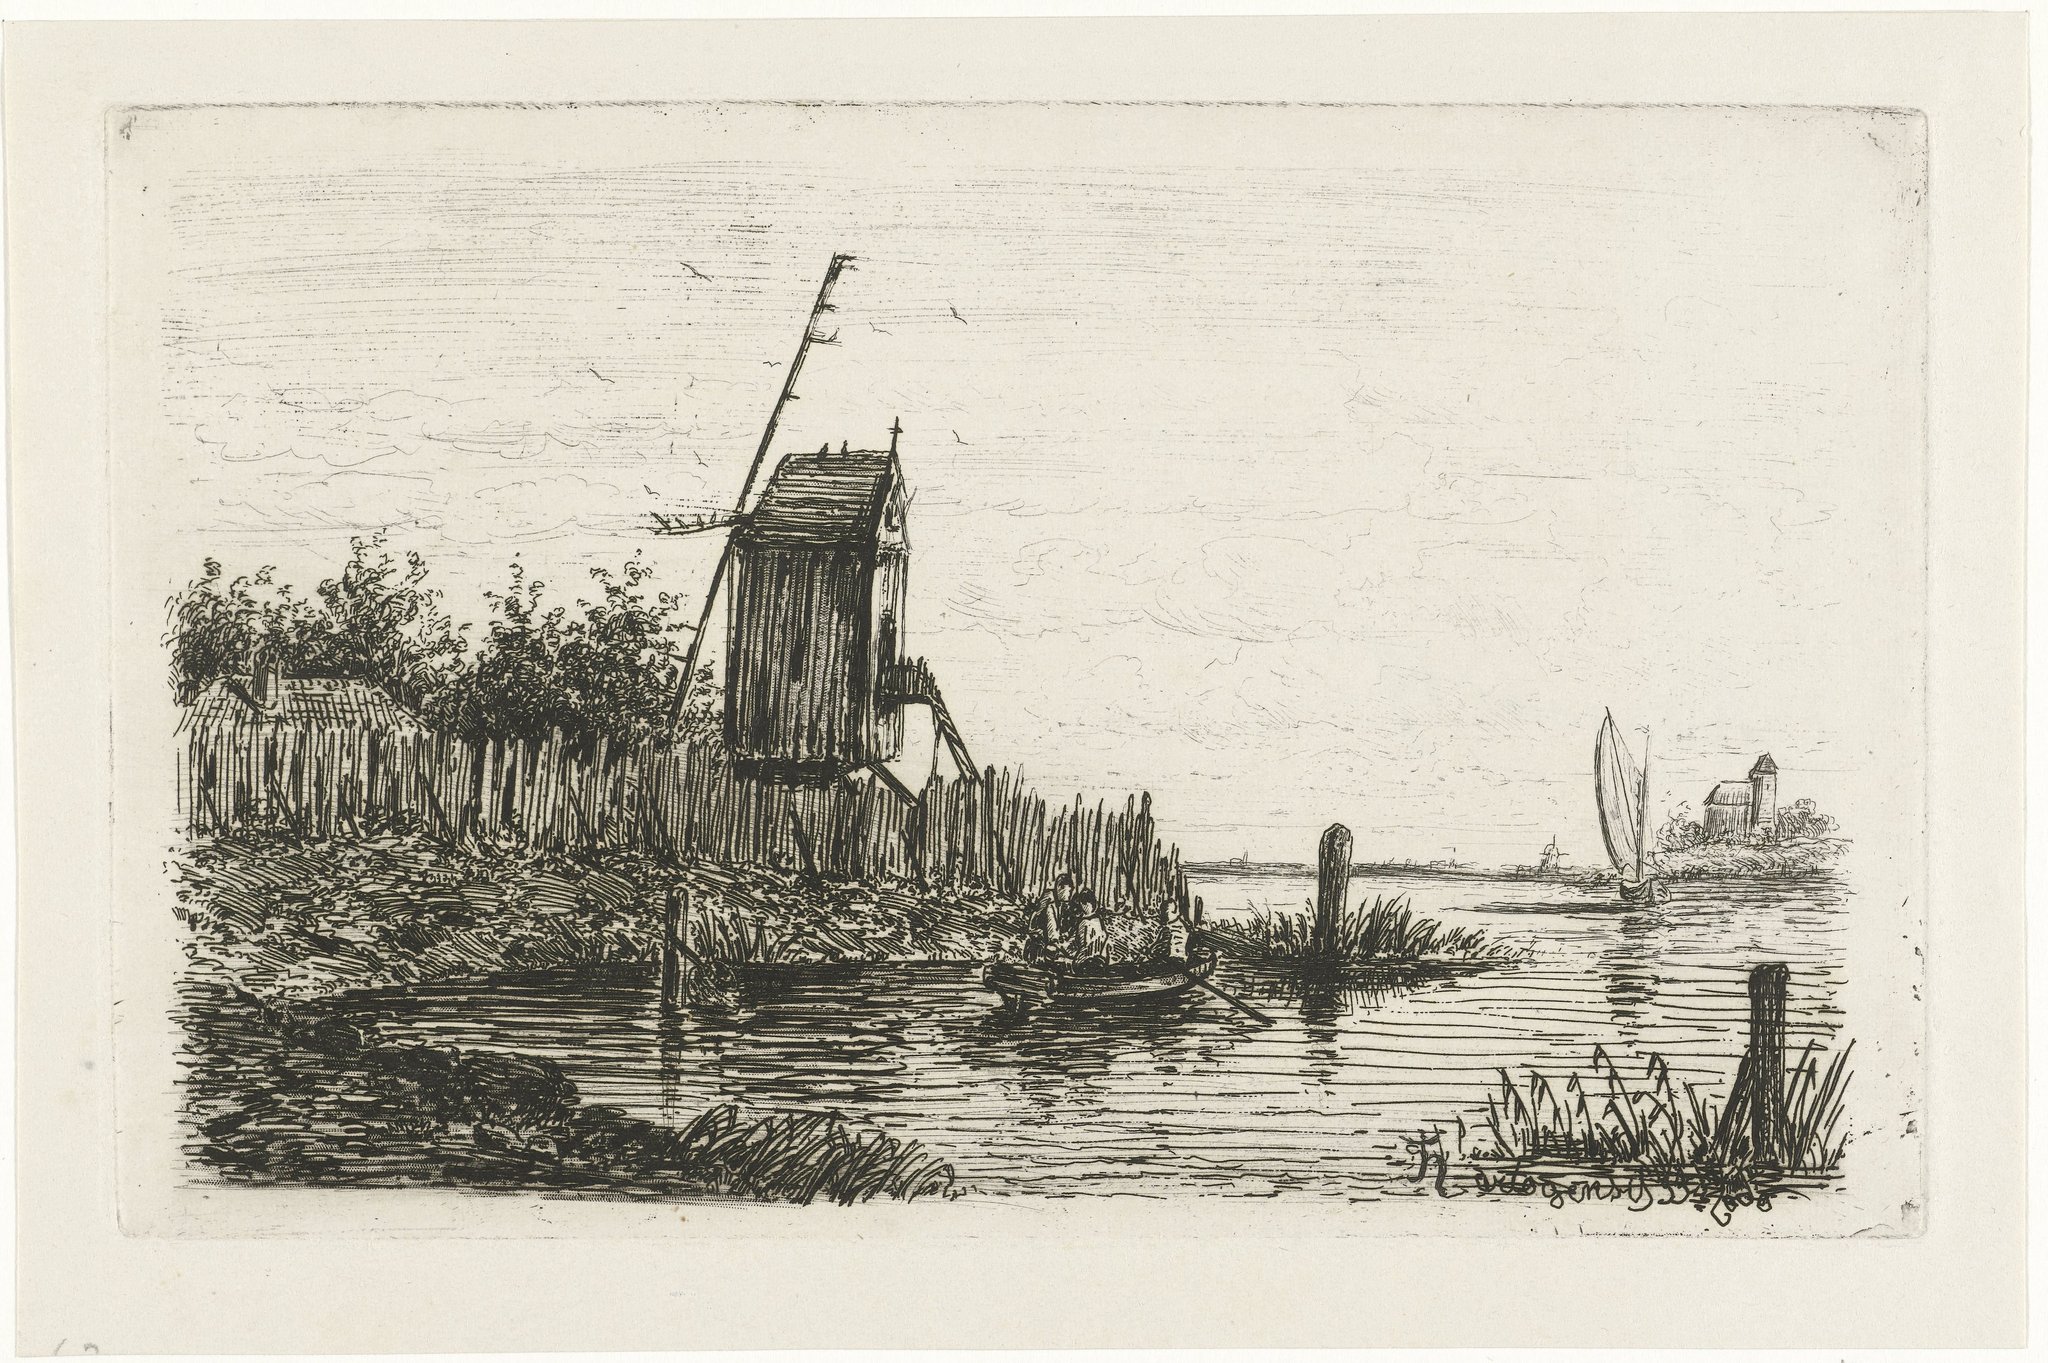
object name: print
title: Molen aan het water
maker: joseph hartogensis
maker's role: painter, print maker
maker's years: 1822-1865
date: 1837-1865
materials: paper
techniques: etching, roulette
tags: windmill in landscape, water course (+ landscape with figures, staffage)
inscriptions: collector's mark: Lugt 2228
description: Drie figuren in een bootje op het water bij een molen.